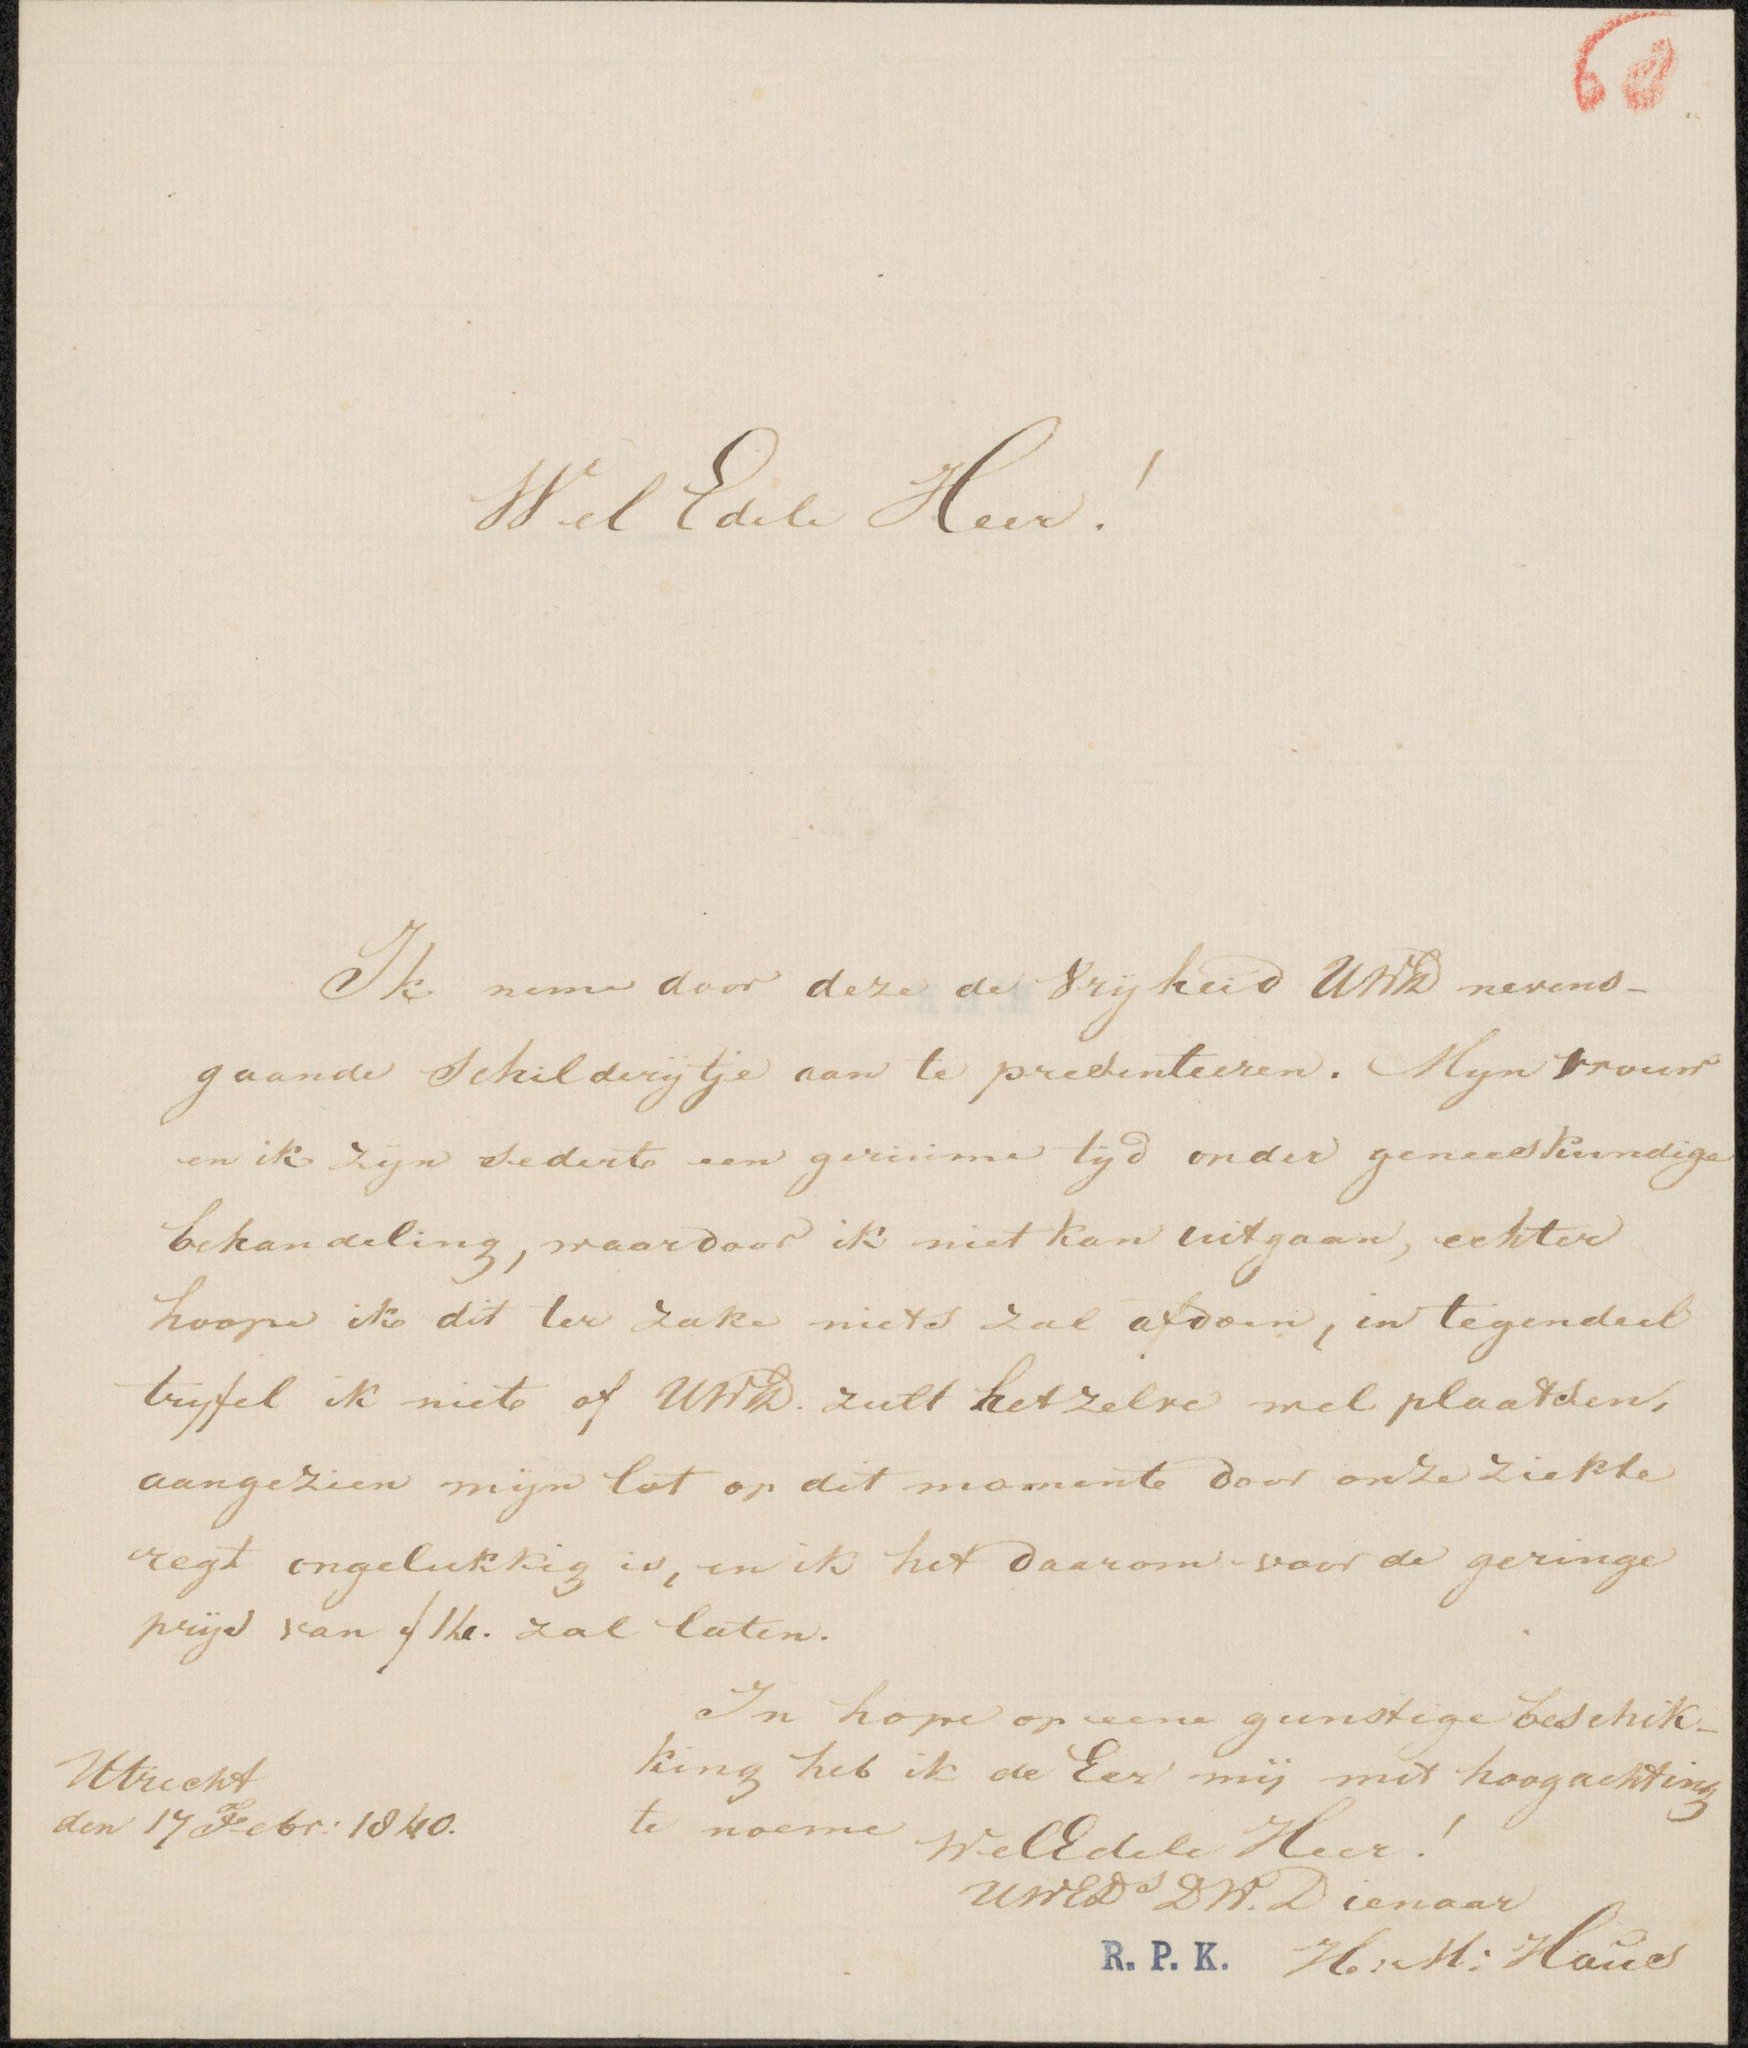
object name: letter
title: Brief aan anoniem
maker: hendrik manfried haus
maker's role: painter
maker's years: 1803-1843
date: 1840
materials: ink, paper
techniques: pen, writing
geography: utrecht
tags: painting (including book-illumination, miniature-painting), exhibition ~ art, diseases, money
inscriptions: collector's mark: Lugt 2233, watermark